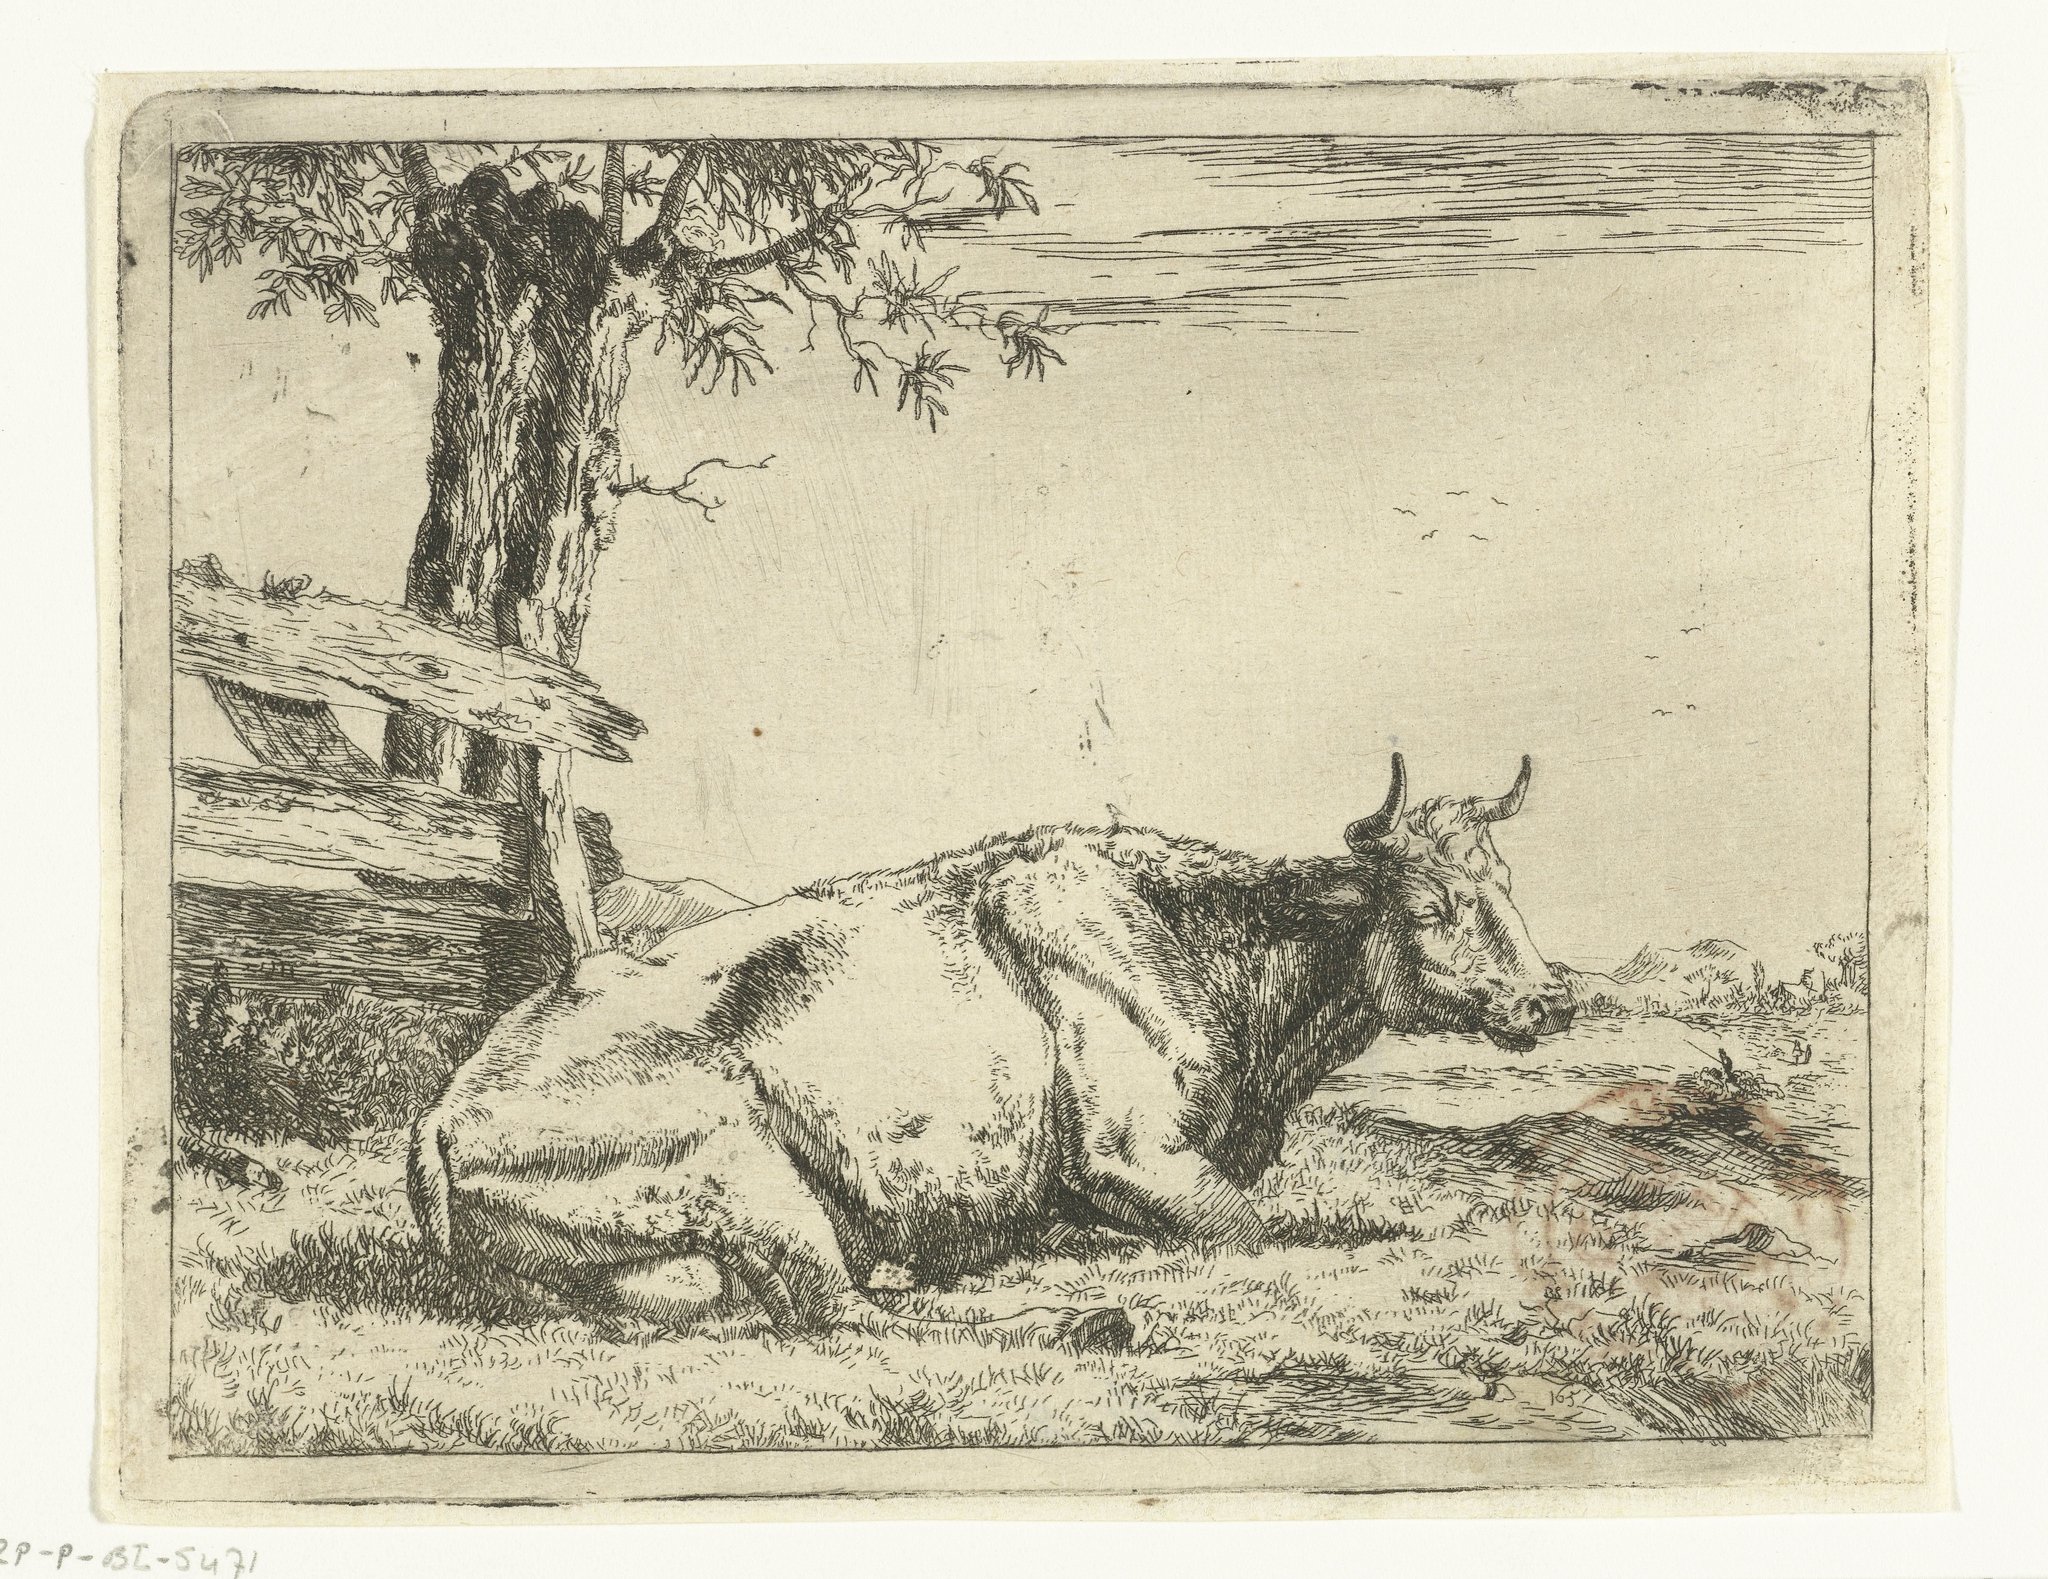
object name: print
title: Rustende koe bij een hek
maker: marcus de bye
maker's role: print maker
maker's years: 1639-1688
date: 1657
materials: paper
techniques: etching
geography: the hague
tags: cow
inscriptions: collector's mark: Lugt 240